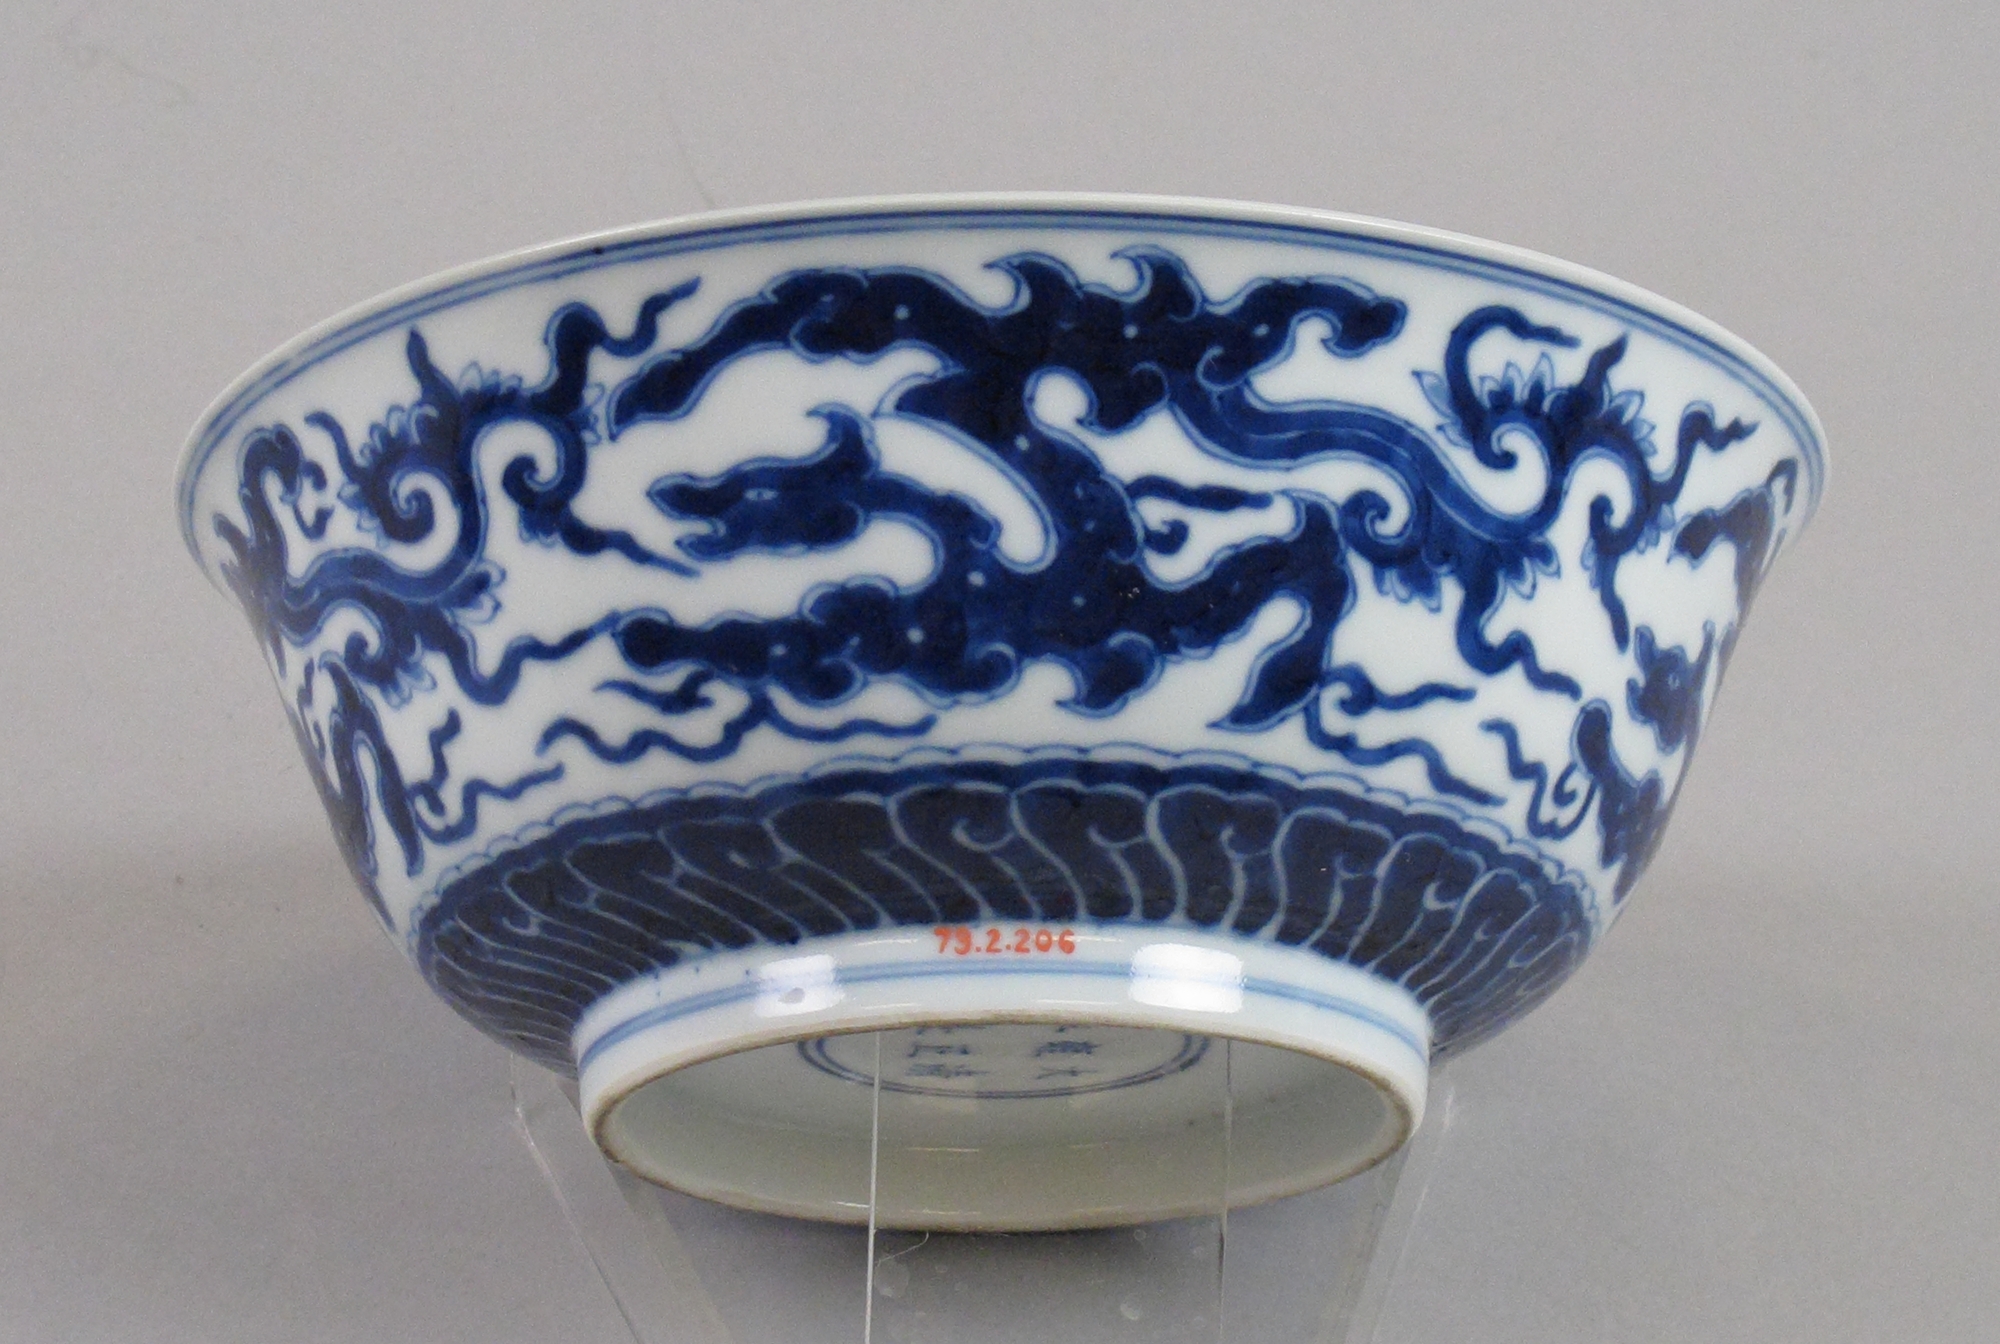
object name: bowl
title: Bowl with chi dragons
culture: chinese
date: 1701-1733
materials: cobalt, porcelain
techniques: painting, underglaze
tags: dragons